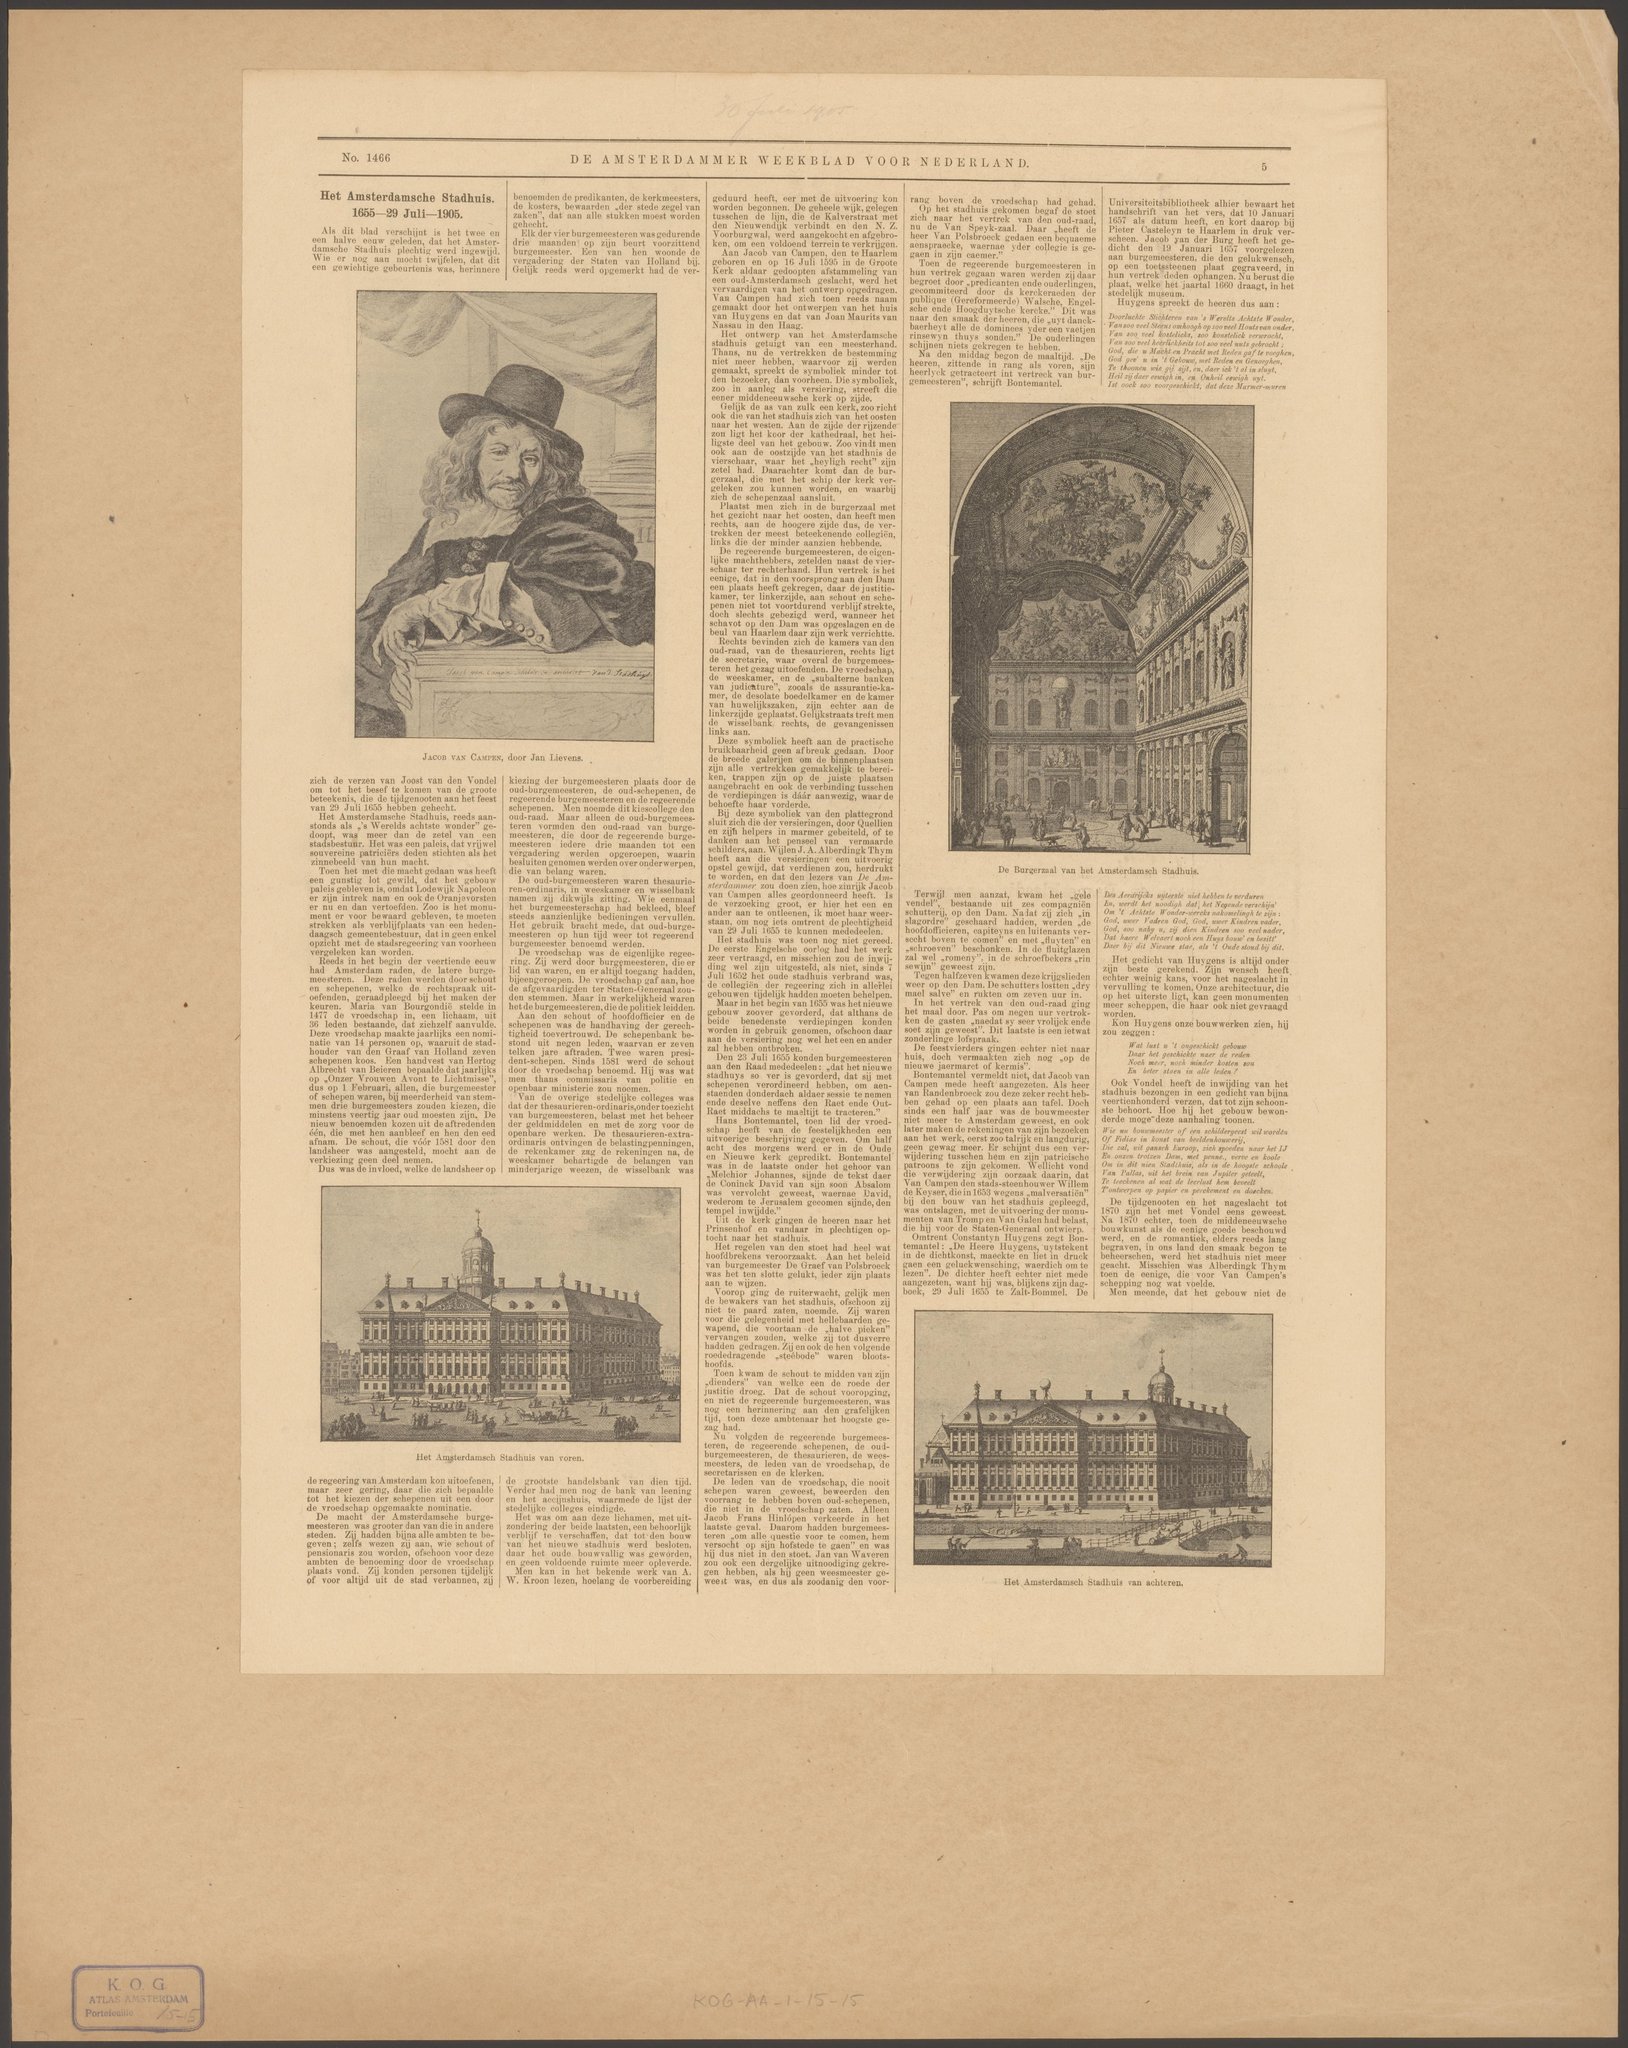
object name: photomechanical print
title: Gezicht op het Stadhuis op de Dam en de Burgerzaal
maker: Anonymous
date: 1905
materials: paper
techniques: letterpress printing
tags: city-view in general; 'veduta', townhall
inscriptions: collector's mark: ‘15-15’ Lugt 1641b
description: Onderwerpsrubriek binnen de Atlas Amsterdam: Nieuwe Stadhuis, als Stadhuis, op de Dam. Bladzijde uit De Amsterdammer, 30 juli 1905.